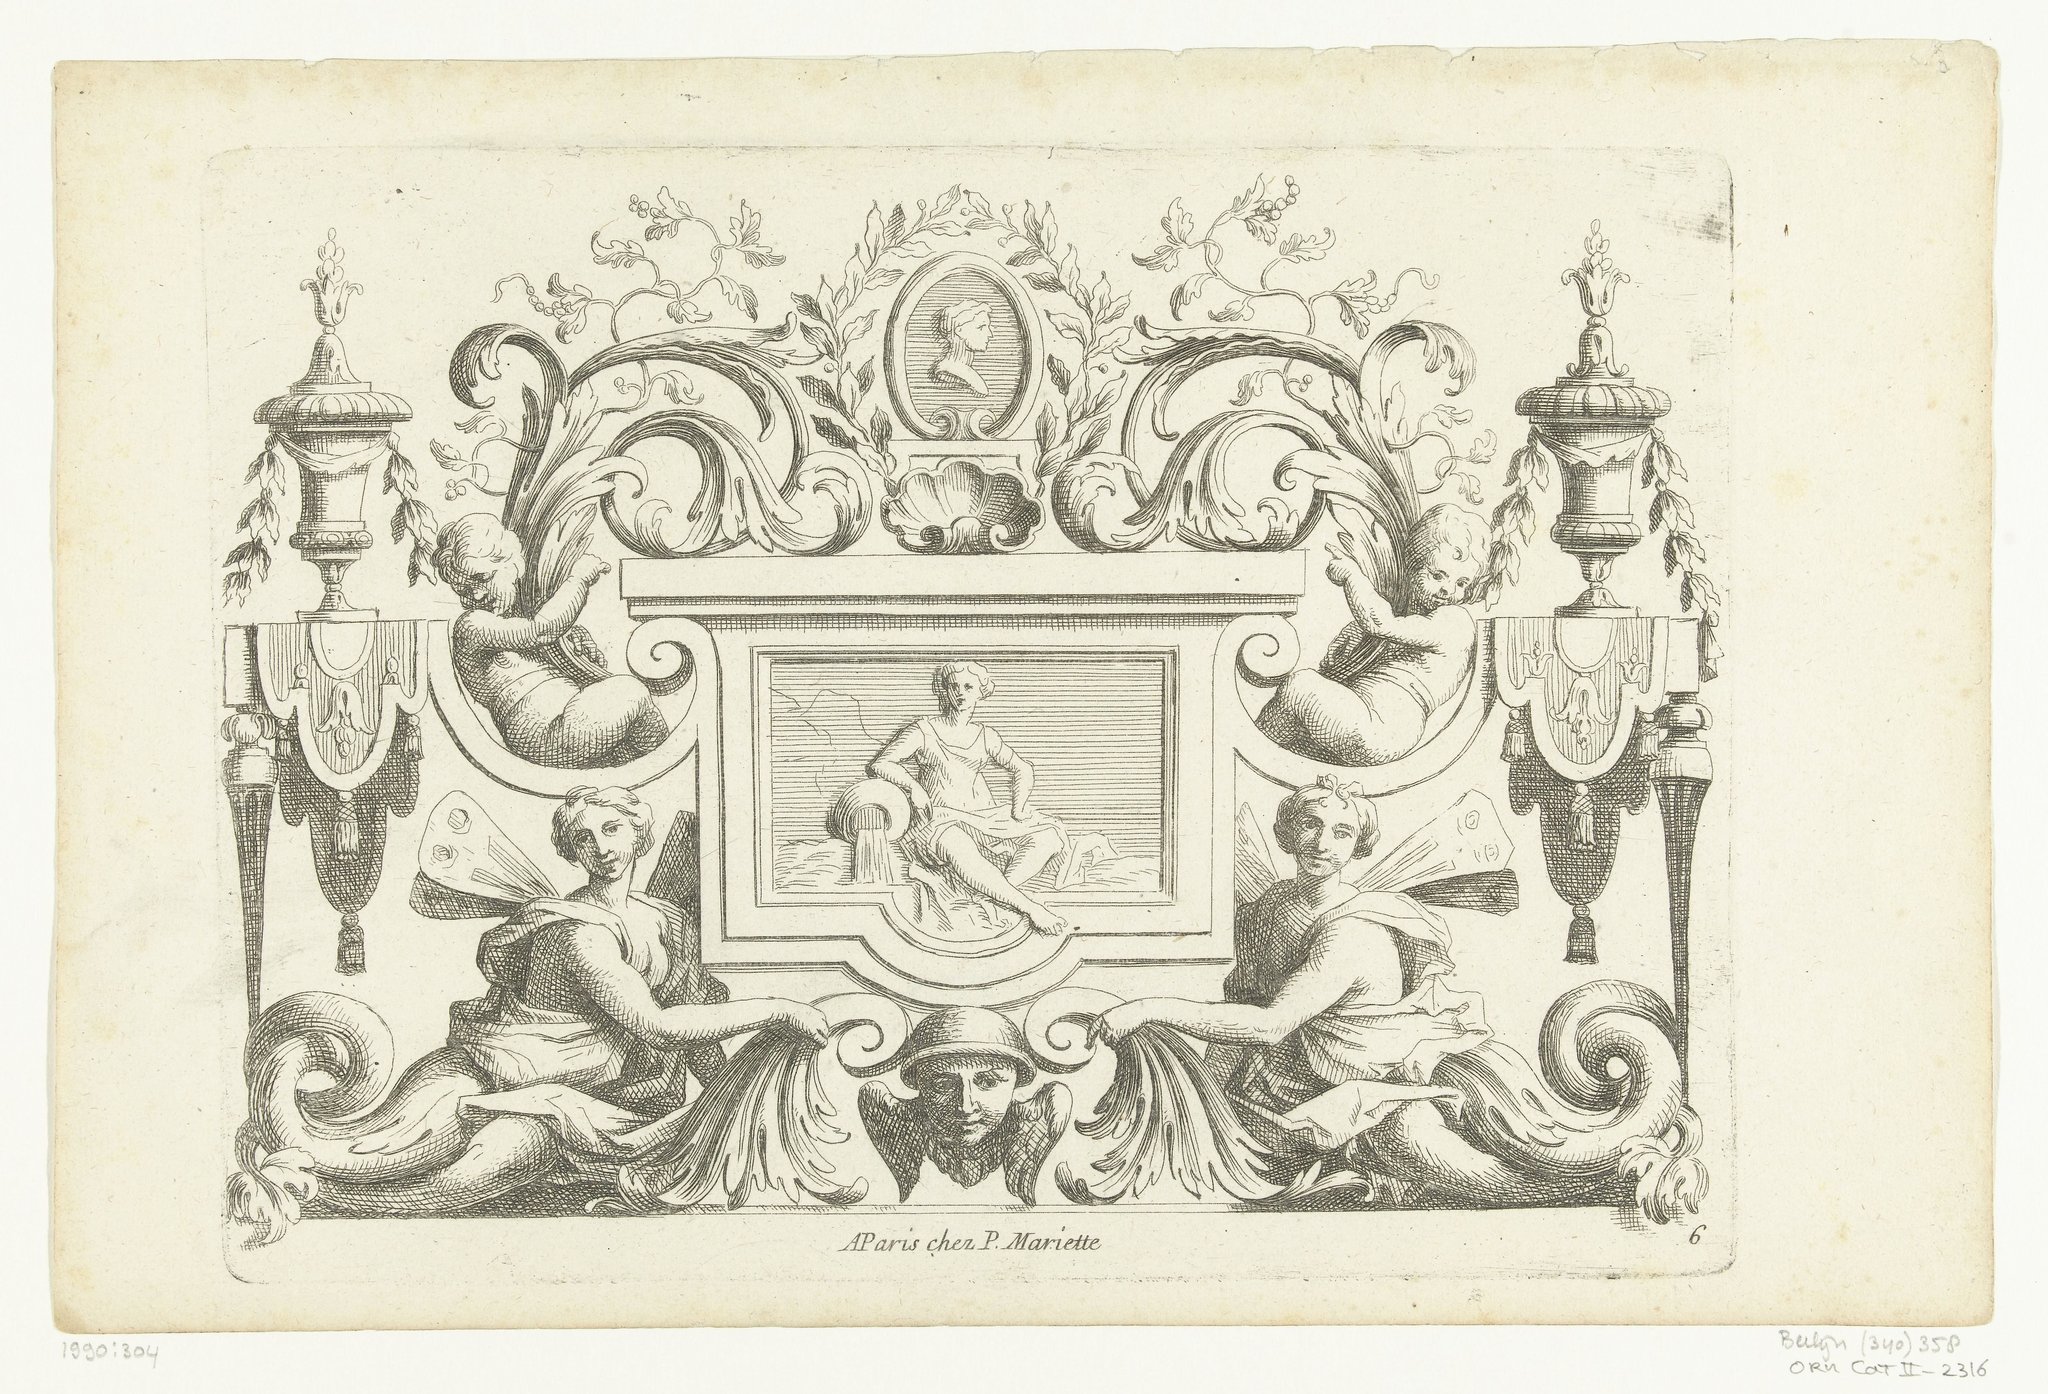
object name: ornament print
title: Rechthoekig paneel met een riviergodin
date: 1670-1680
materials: paper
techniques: engraving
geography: paris